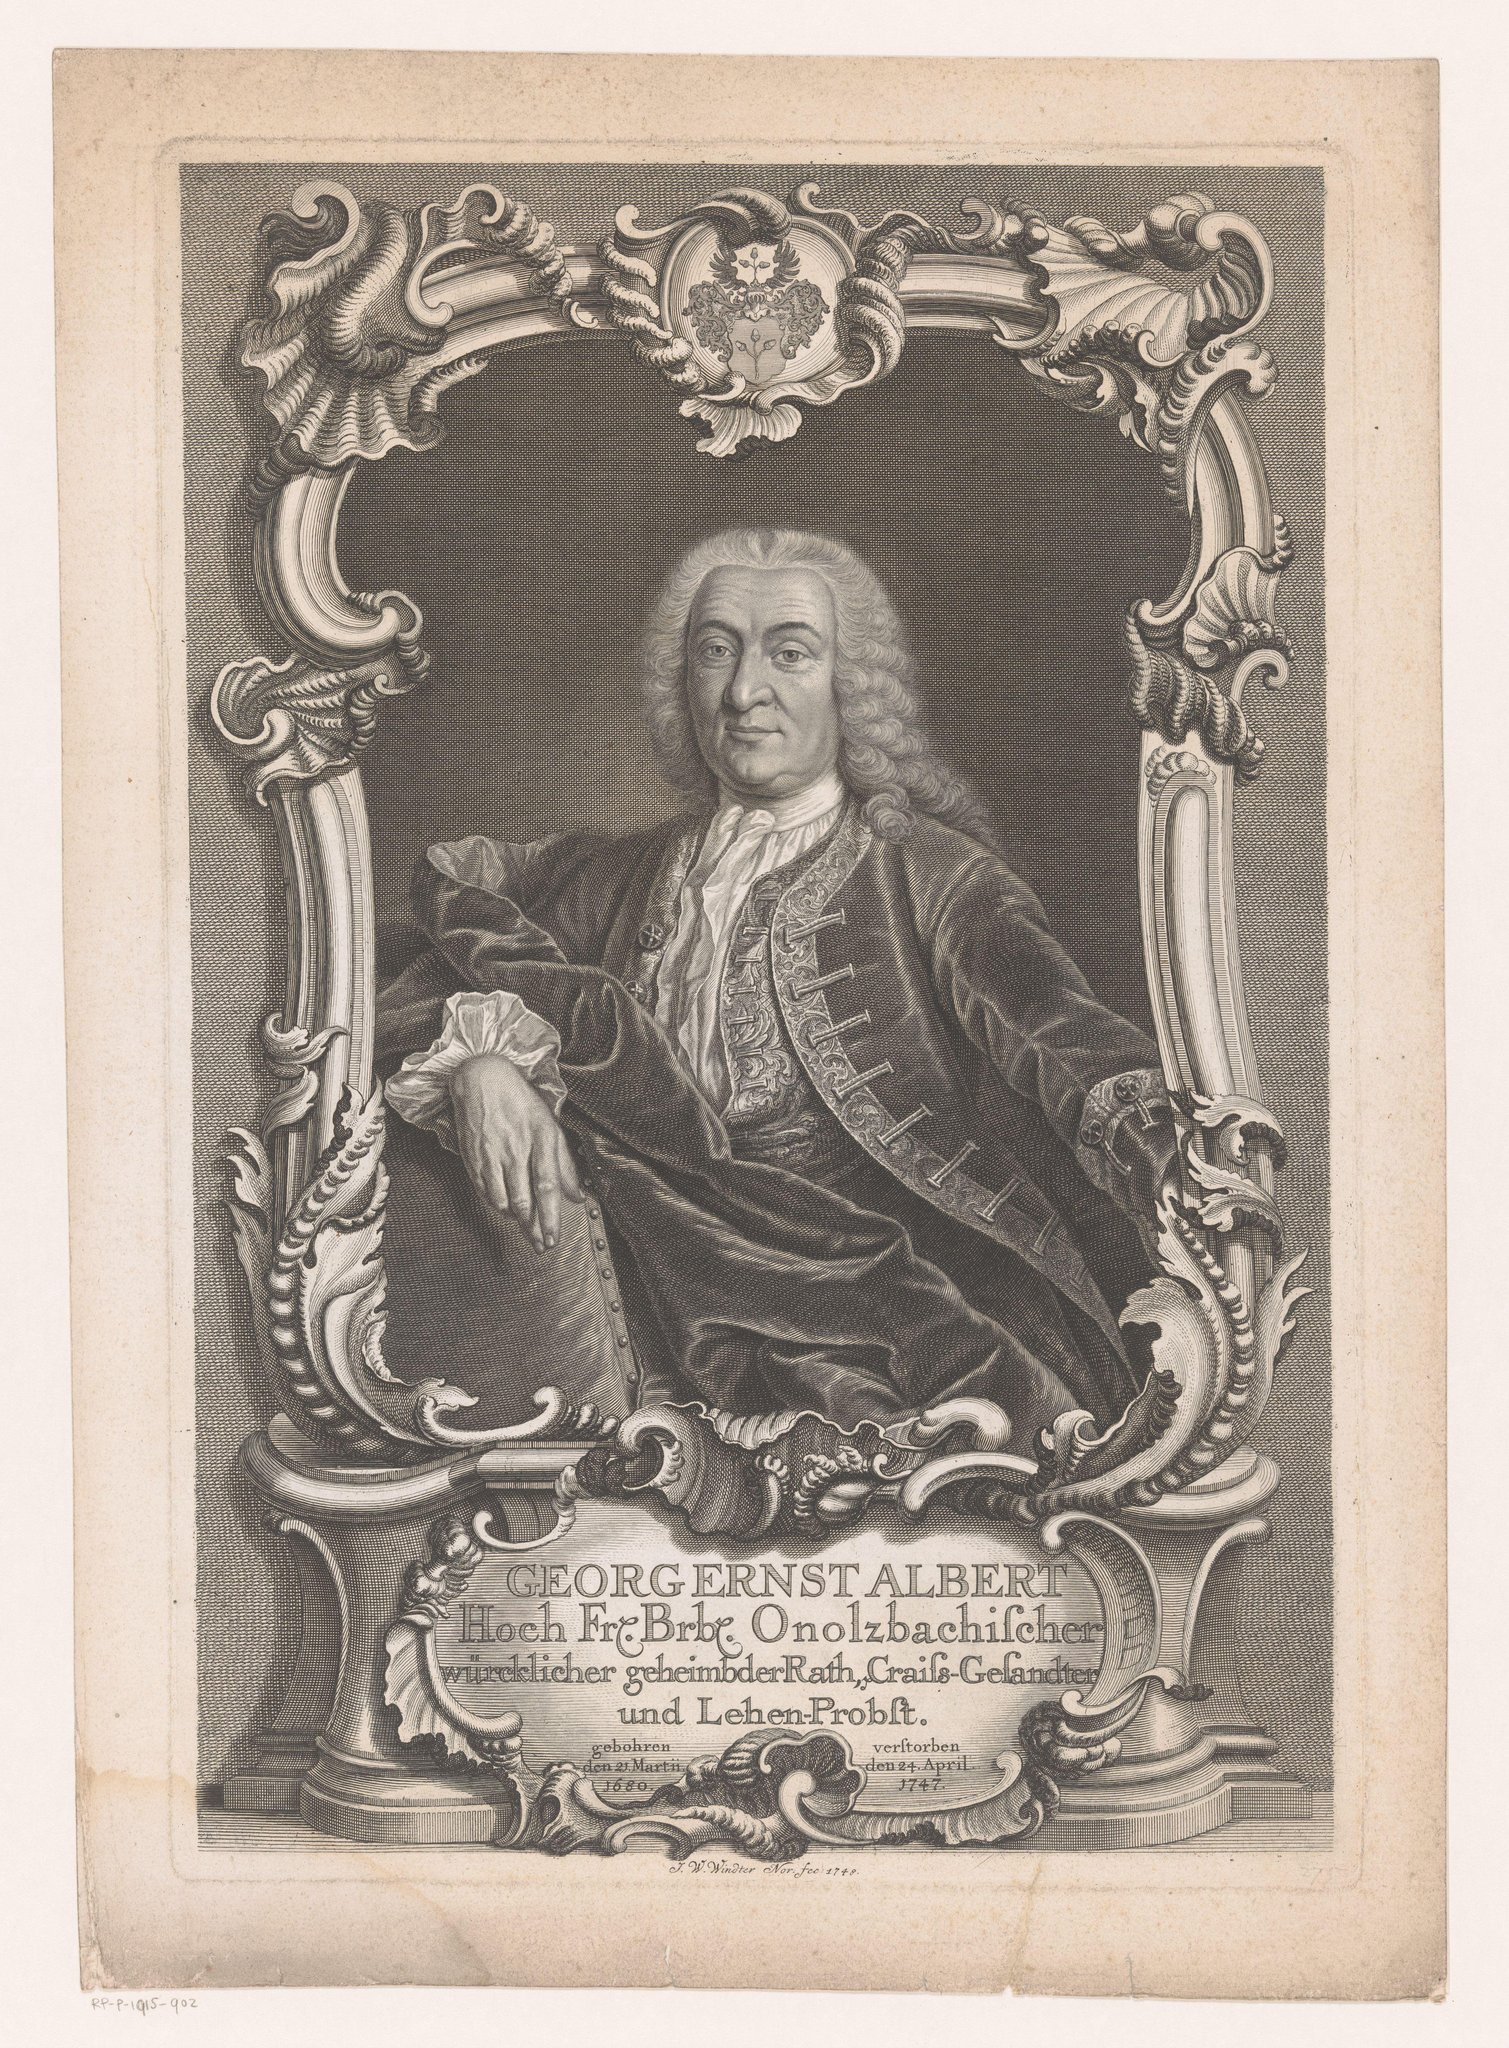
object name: print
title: Portret van Georg Ernst Albert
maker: johann wilhelm windter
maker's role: draughtsman, print maker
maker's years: 1696-1765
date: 1748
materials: paper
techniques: engraving, etching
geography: nuremberg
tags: historical persons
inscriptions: collector's mark: Lugt 2228, inscription: ‘G. Storck a Milano 1798 In Ao 4743’